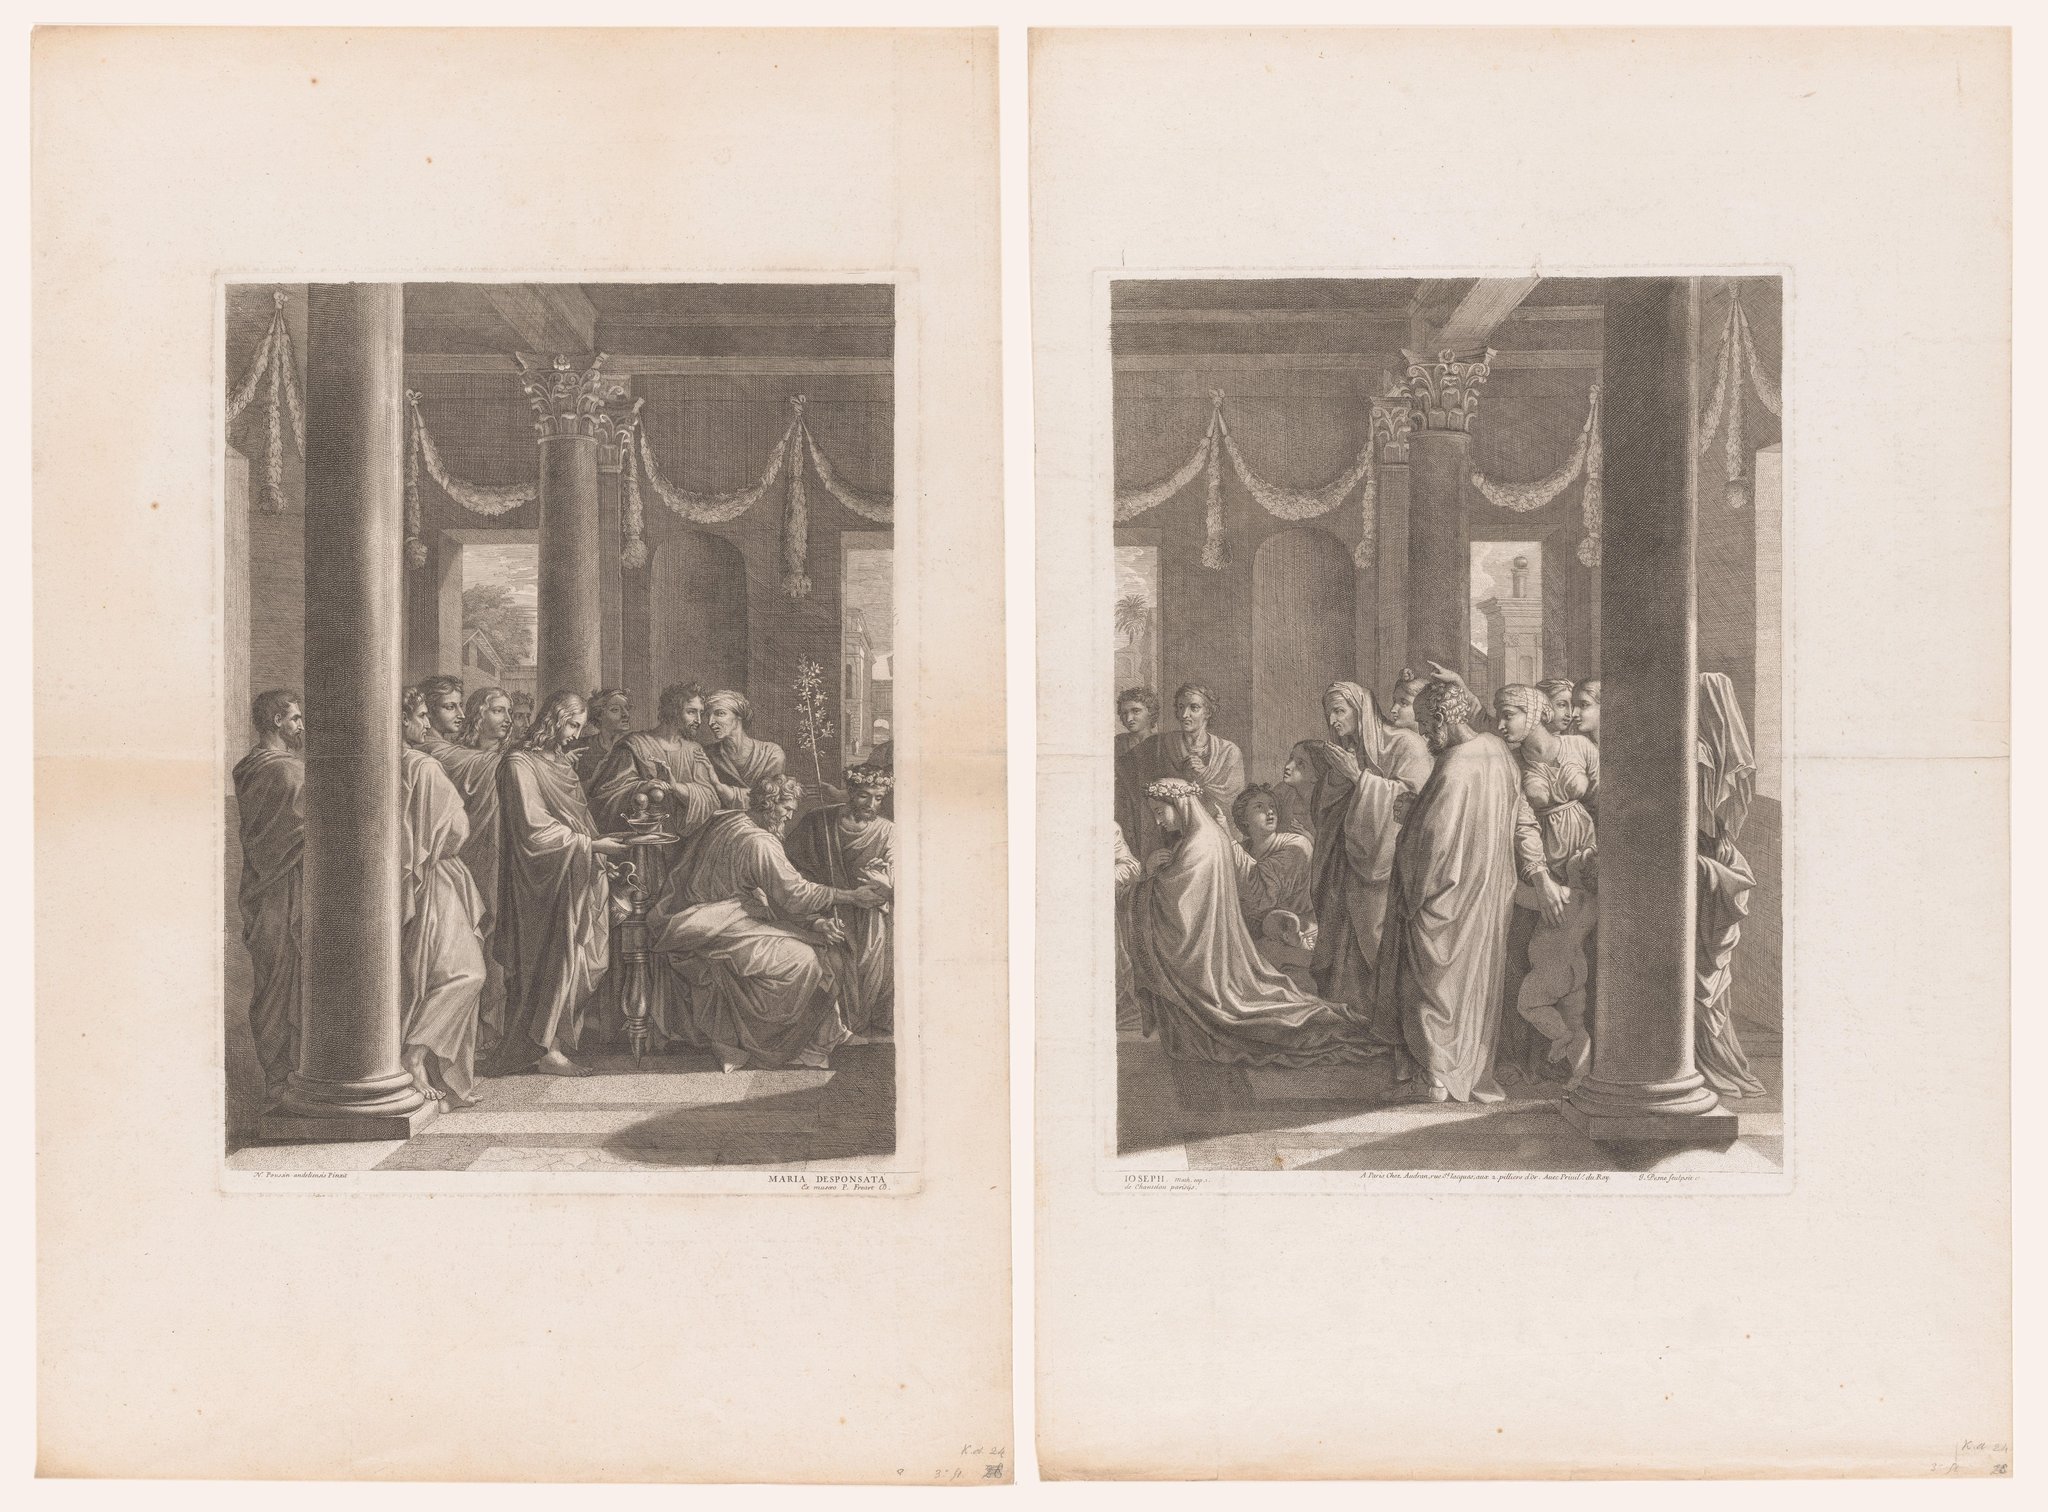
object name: print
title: Zeven sacramenten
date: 1680-1694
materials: paper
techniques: etching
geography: france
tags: marriage in church ~ the sixth of the seven sacraments, marriage of mary and joseph, 'sposalizio': they are married by the high priest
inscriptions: collector's mark: Lugt 240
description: Prent maakt deel uit van een ongenummerde serie van zeven prenten. Dit object is omwille van een betere presentatie virtueel samengevoegd, maar bestaat fysiek uit losse onderdelen.